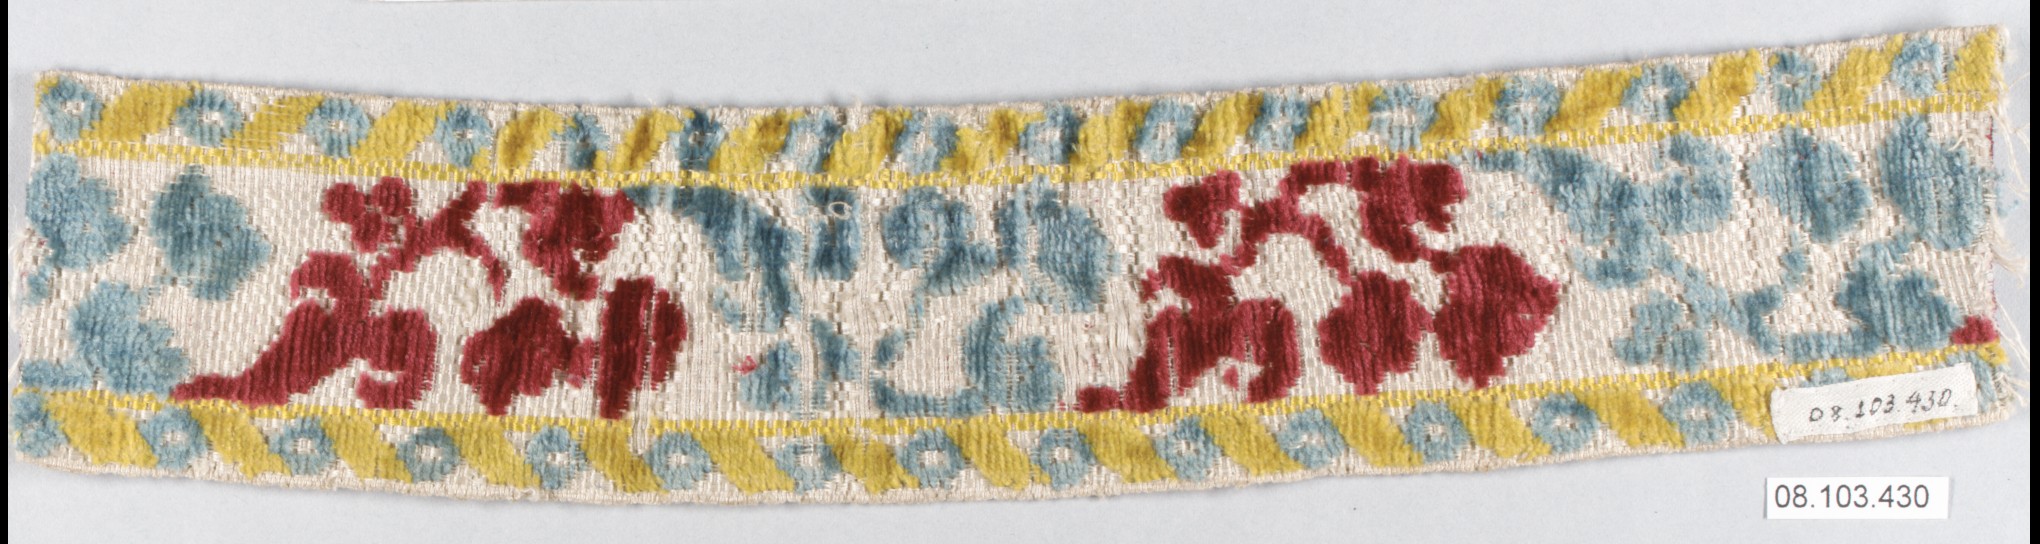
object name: galloon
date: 1701-1900